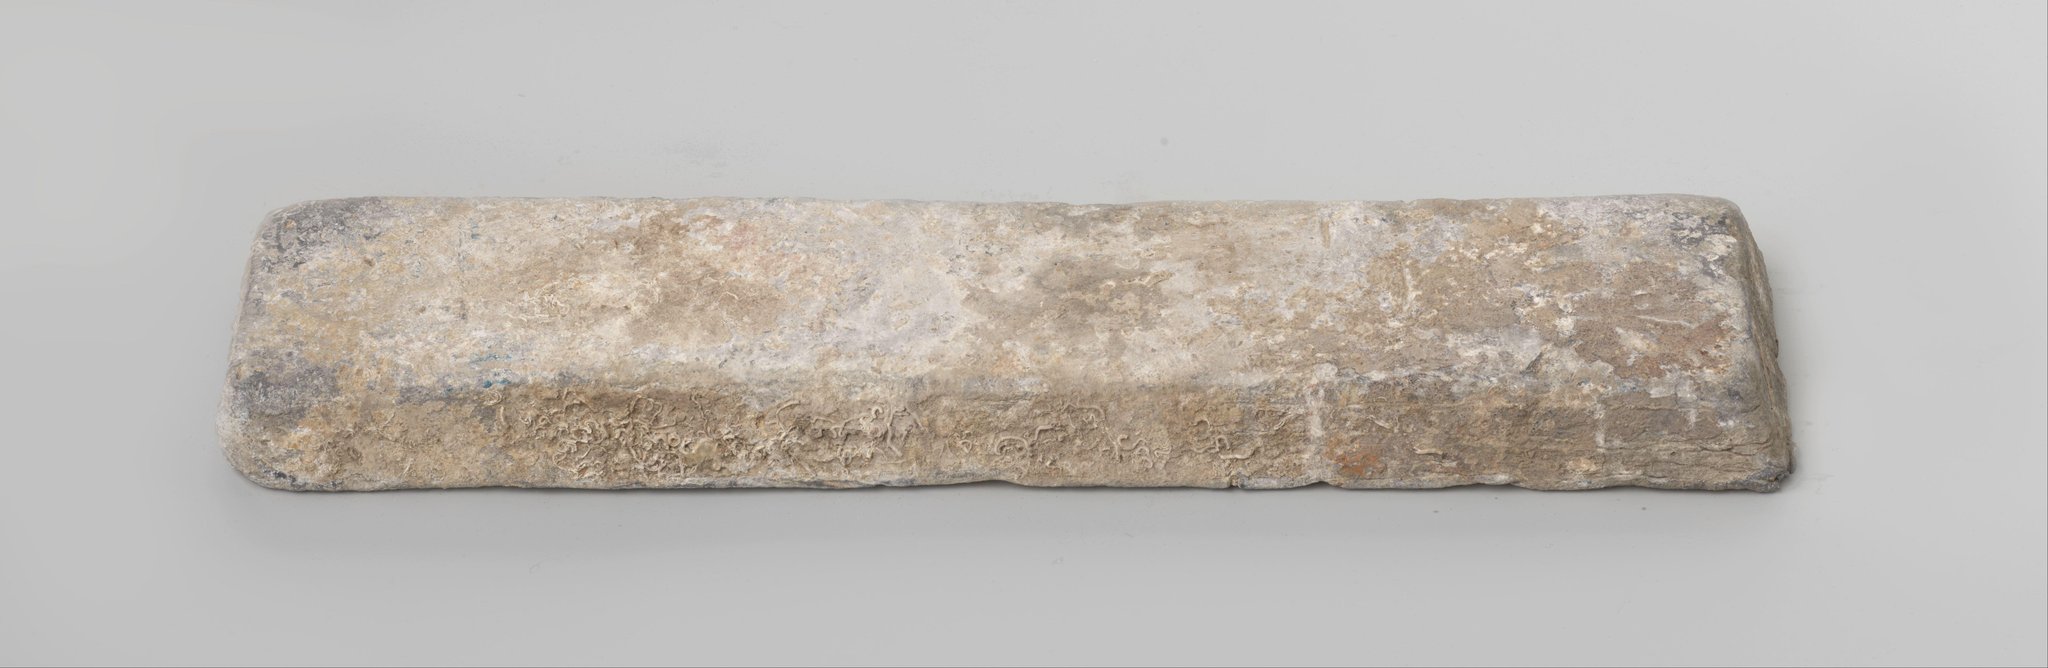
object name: ingot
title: Lead ingot used as ballast from the wreck of the Dutch East Indiaman Hollandia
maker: Anonymous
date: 1700-1743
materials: lead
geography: netherlands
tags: verenigde oostindische compagnie, hollandia (schip), annet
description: Ingot; (1) corroded, oblong, straight, rectangular ends, flat upper side (75l, 17.5w, 6h), tapered underside.